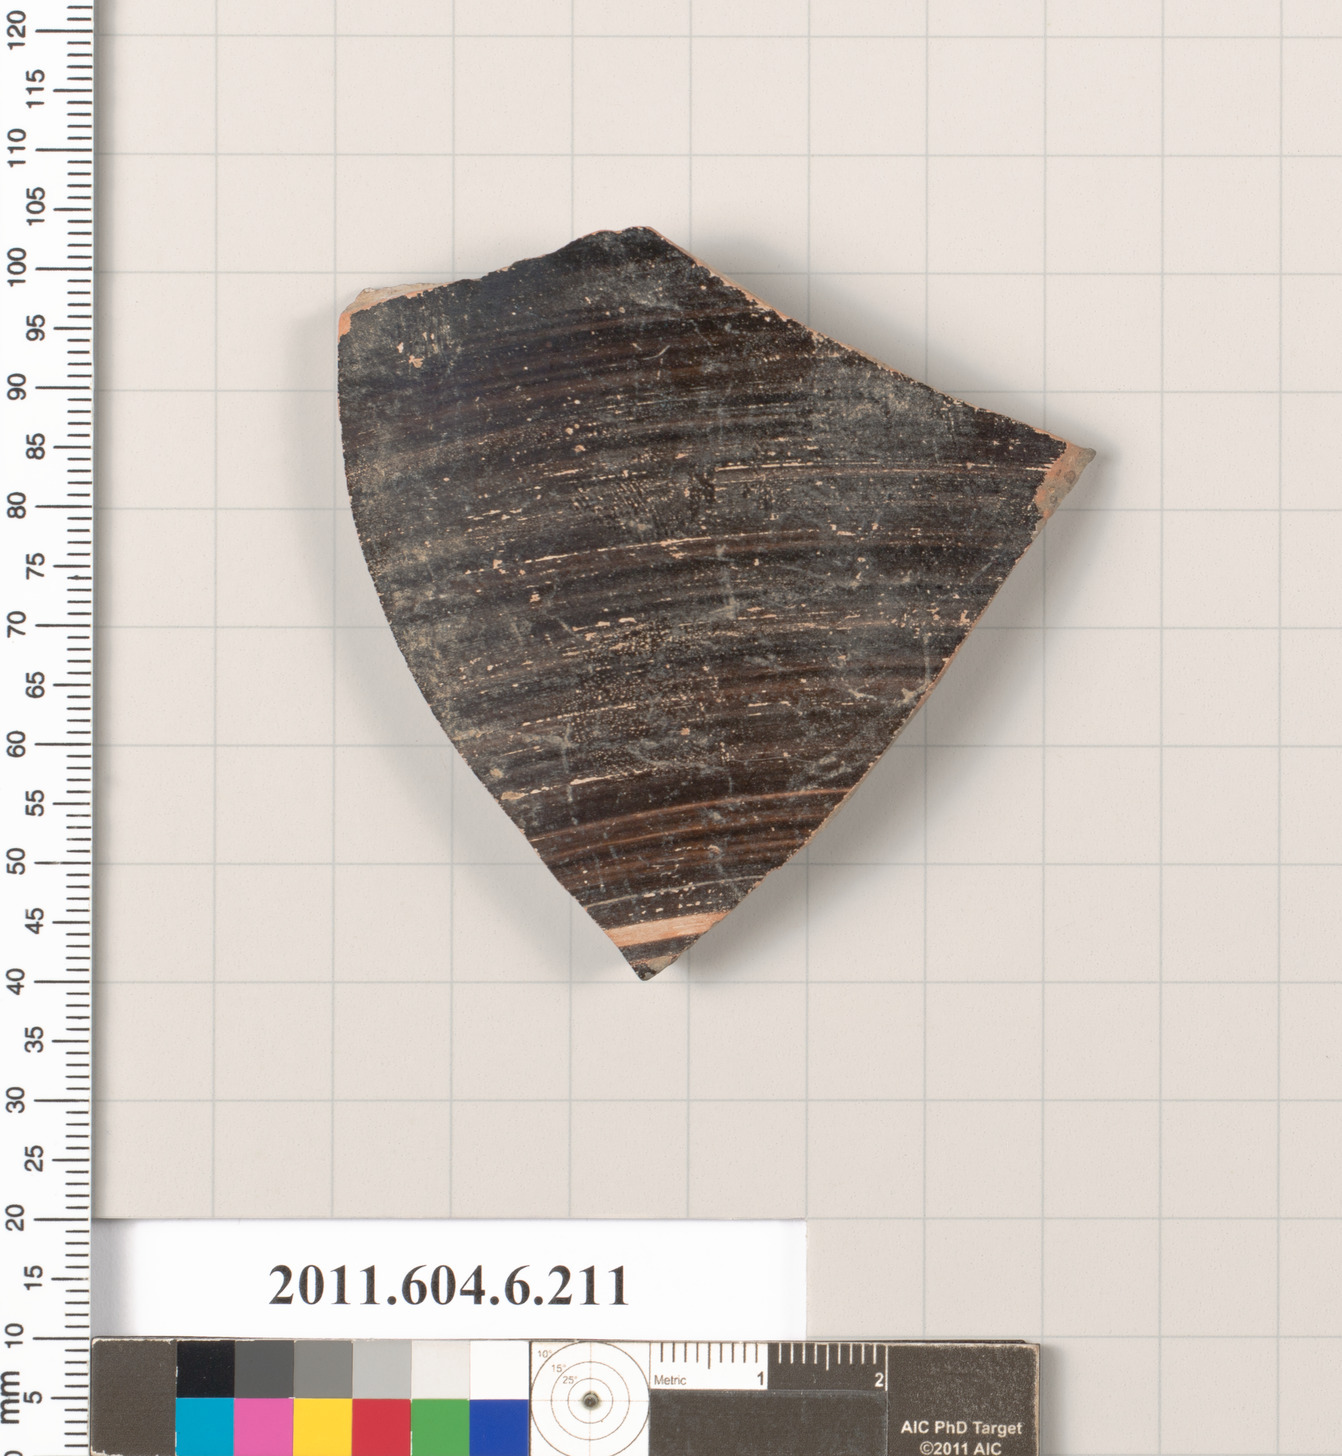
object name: skyphos fragment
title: Terracotta fragment of a skyphos (deep drinking cup)?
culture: greek, attic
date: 500-401 BCE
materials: terracotta